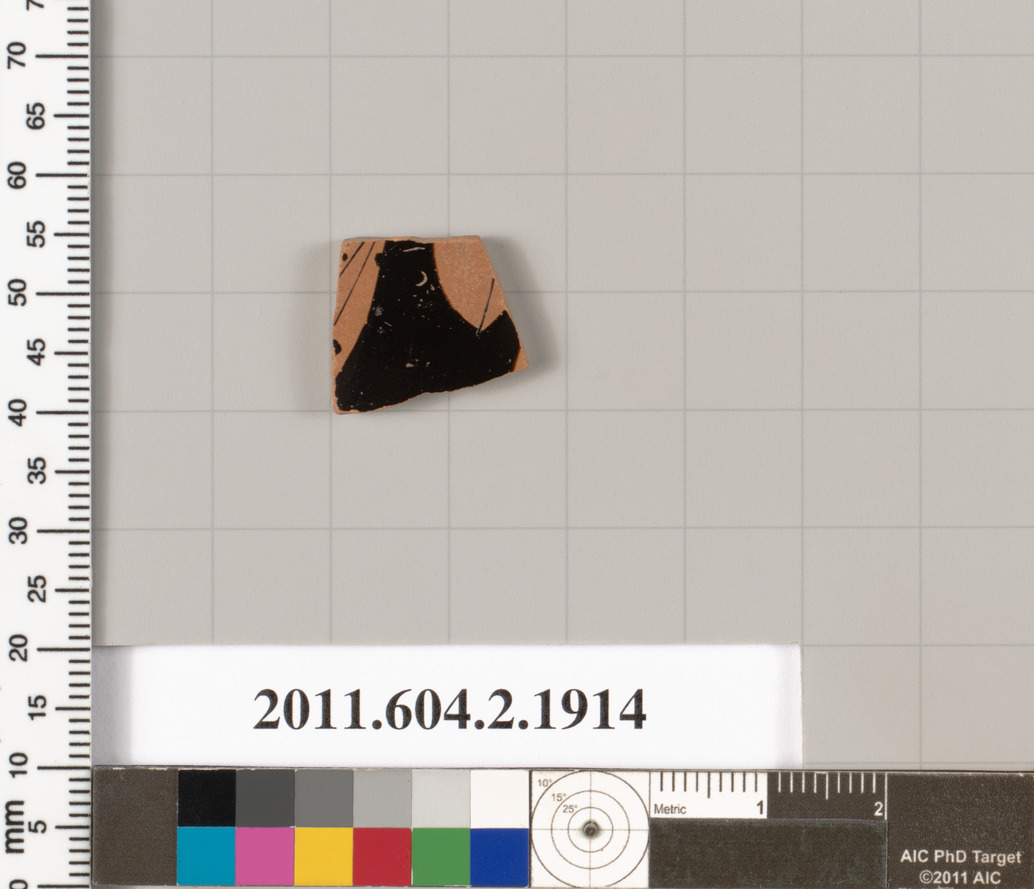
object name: skyphos fragment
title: Terracotta fragment of a skyphos (deep drinking cup)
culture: greek, attic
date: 460-430 BCE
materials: terracotta